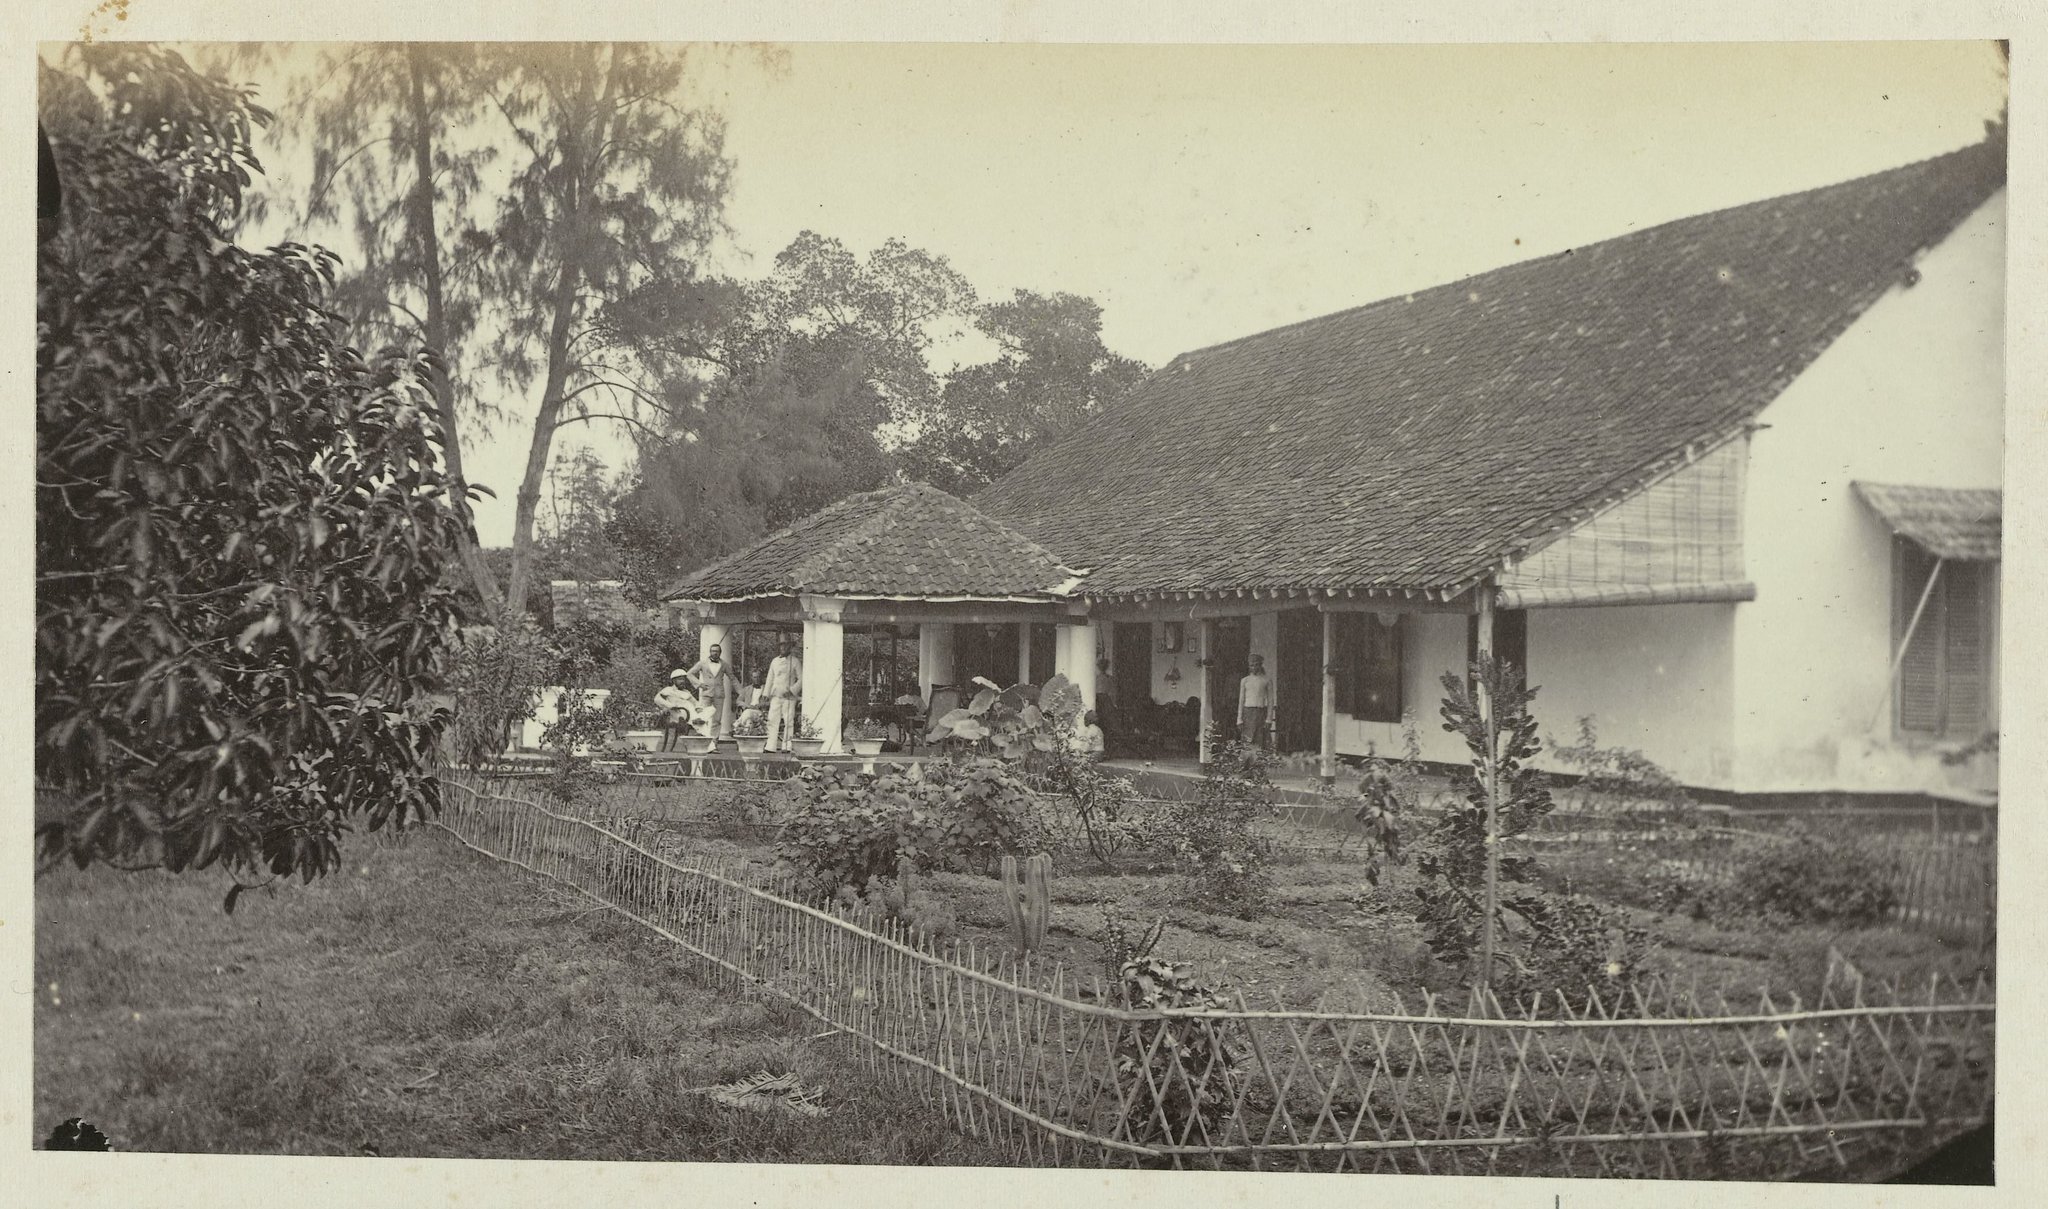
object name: photograph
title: Huis met tuin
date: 1863-1869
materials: photographic support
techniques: albumen print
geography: dutch east indies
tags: country-house, dutch east indies, the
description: Een woonhuis met een omheinde tuin. Onderdeel van het groene fotoalbum met foto's van Java, uit het bezit van apotheker Specht-Grijp, die in 1865 vanuit Batavia naar Nederland terugkeerde.